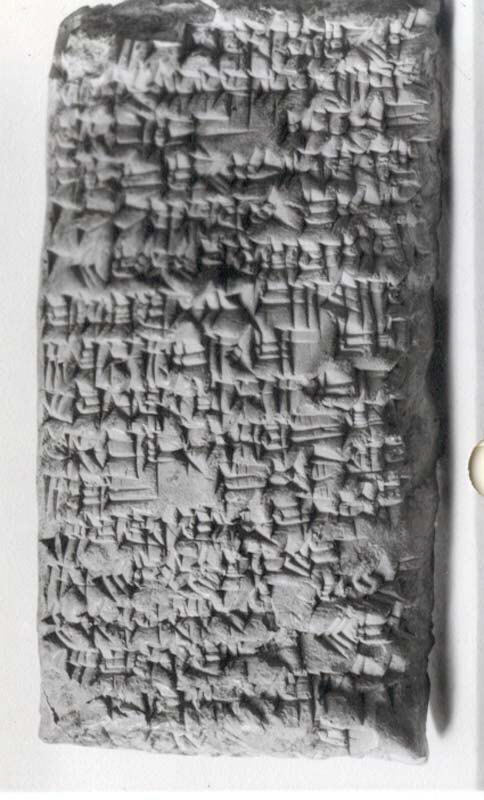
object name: cuneiform tablet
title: Cuneiform tablet: litigation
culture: babylonian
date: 1726 BCE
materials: clay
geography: mesopotamia